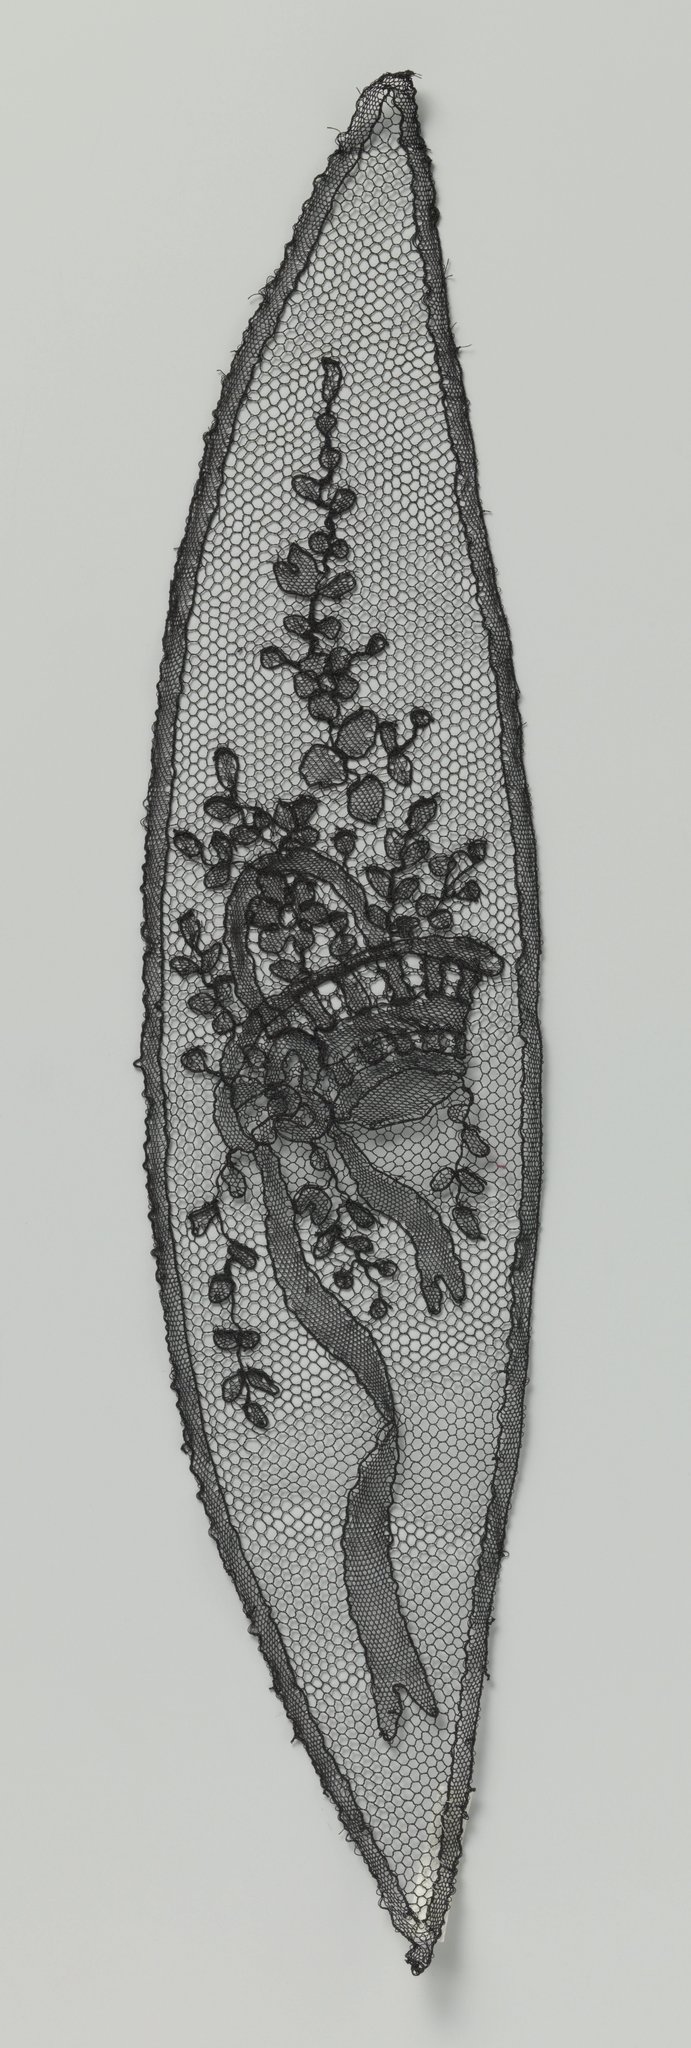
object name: kousinzet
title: Spitsovaalvormige kousinzet van kloskant met bloemenmand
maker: Anonymous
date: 1911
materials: silk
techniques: lace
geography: geraardsbergen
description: Kousinzet van zwarte kloskant: Chantilly-kant. Spitsovaalvormig model. Het patroon bestaat uit een bloemenmand met linten, die tot in de punt van de kousinzet hangen. De motieven zijn gemaakt in netslag met dikkere contourdraden. Ze zijn met elkaar verbonden door een zeshoekige traliegrond, een tulegrond. Als siergrond is spaarzaam een rozengrond toegepast. Langs de omtrek van de kousinzet is een randje in netslag gemaakt, die aan binnen en buitenzijde is afgewerkt met een dikkere contourdraad.